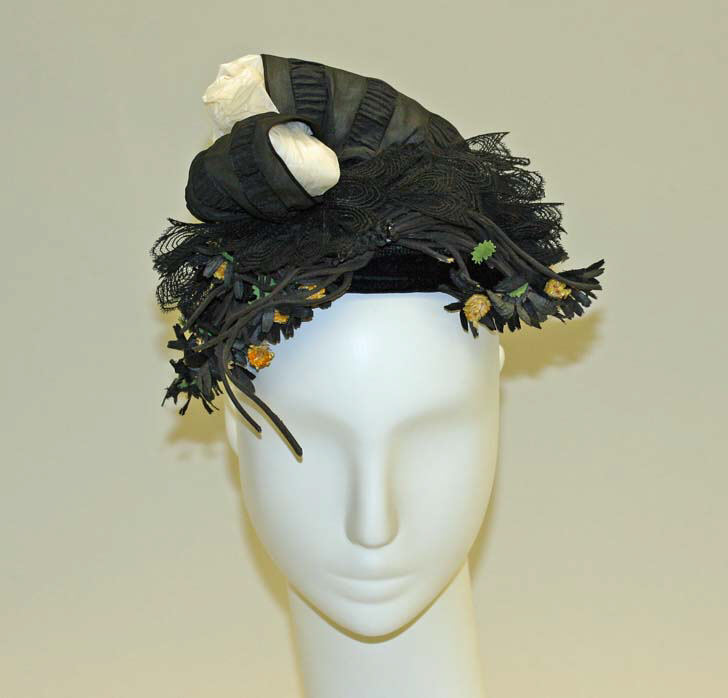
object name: hat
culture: american or european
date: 1880-1889